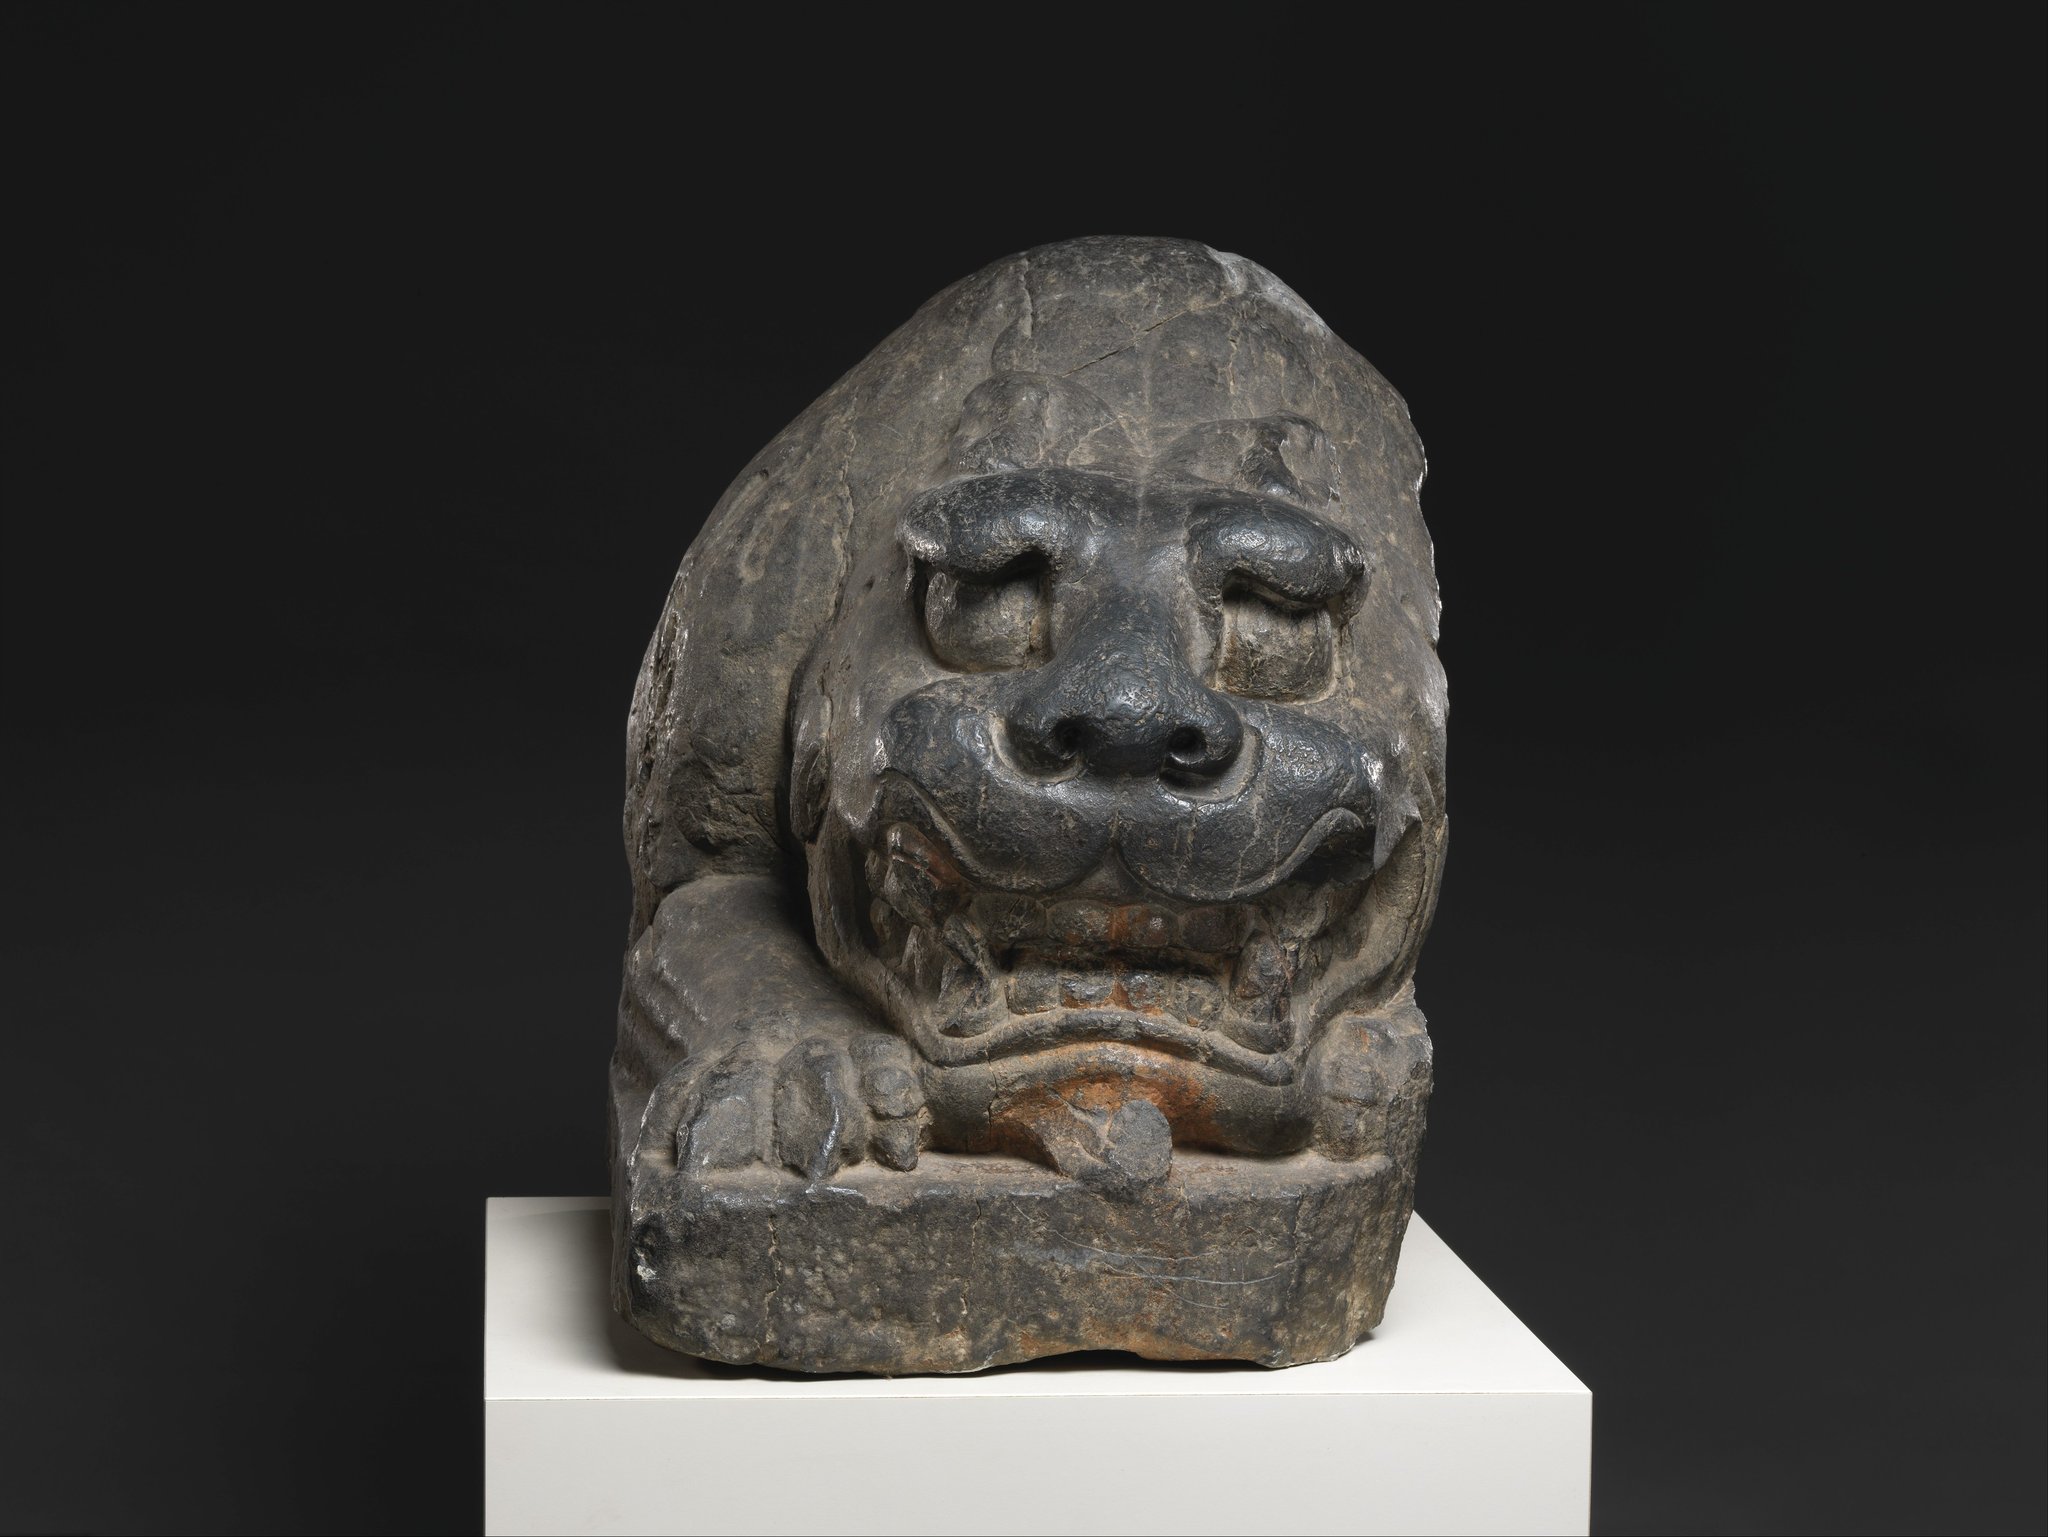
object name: figure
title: Guardian Lion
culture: chinese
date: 534-566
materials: limestone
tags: lions